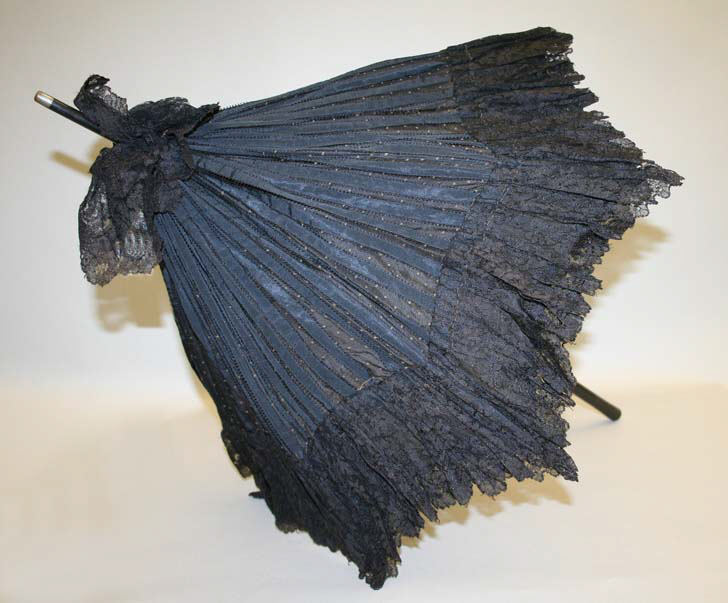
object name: parasol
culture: european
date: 1894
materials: silk